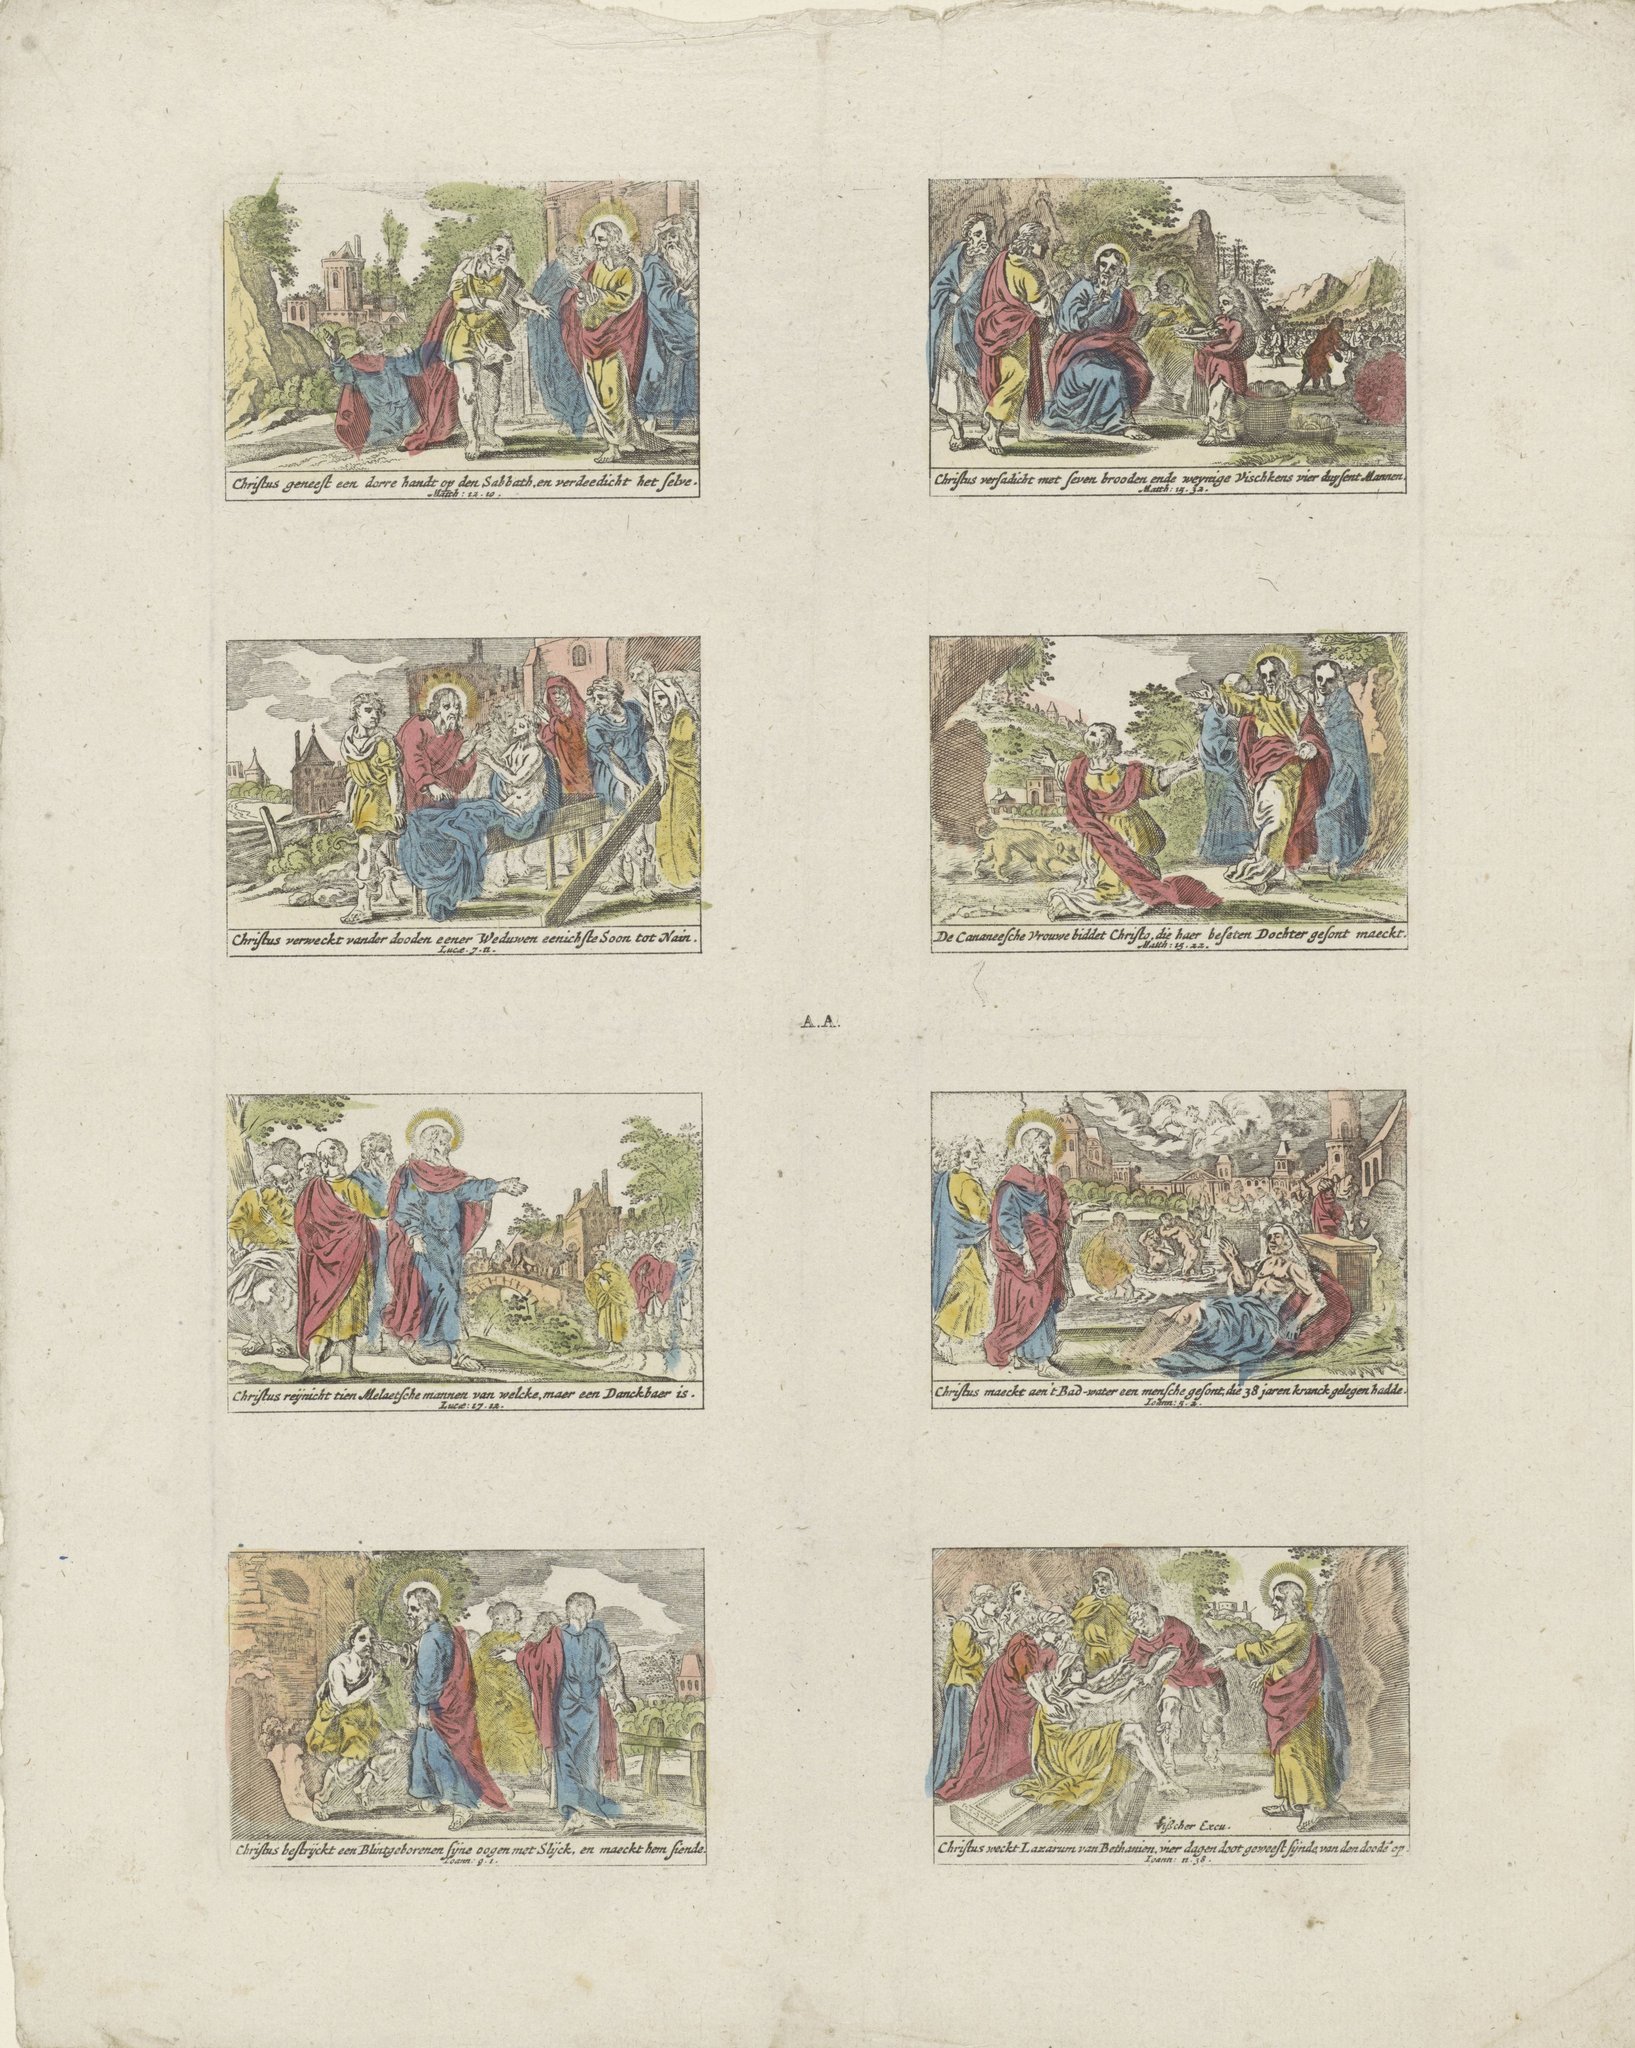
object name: print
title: Voorstellingen uit het Nieuwe Testament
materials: paper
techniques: etching, hand coloring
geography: netherlands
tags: miracles of christ: raising of the dead, christ healing blind people, new testament, miracles of christ ~ healing the sick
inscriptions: collector's mark: Lugt 2760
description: Blad met 8 voorstellingen van wonderen verricht door Christus beschreven in het Nieuwe Testament, waaronder het genezen van zieken en het opwekken van doden. Onder elke afbeelding een onderschrift en bijbehorende Bijbelverwijzing. Gemerkt midden: A.A.